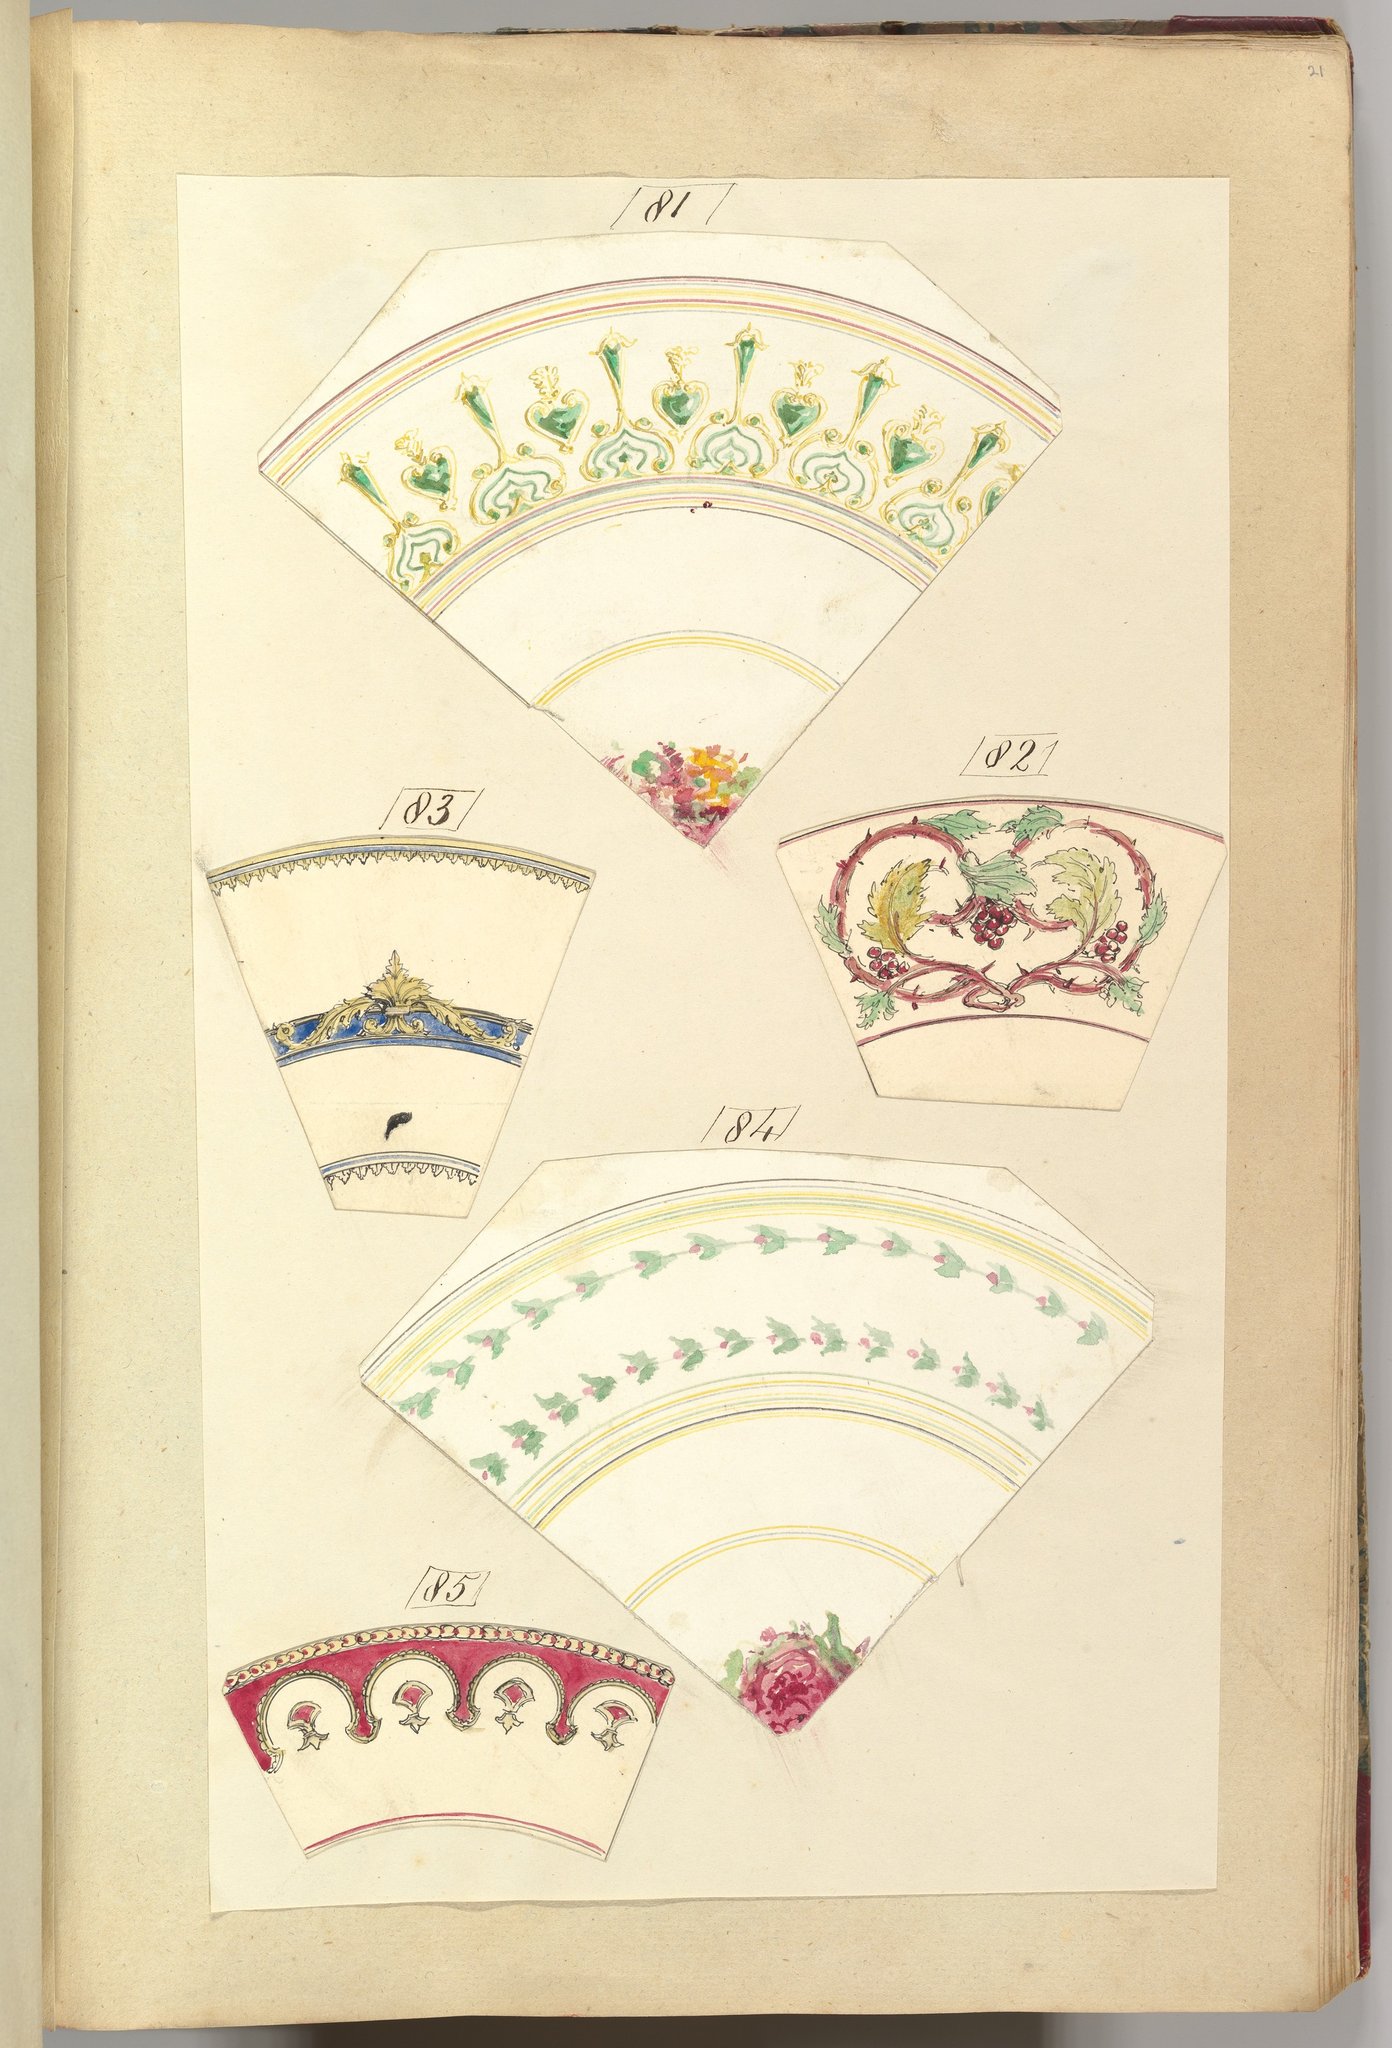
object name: drawing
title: Five Designs for Decorated Plates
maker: alfred henry forrester [alfred crowquill]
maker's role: artist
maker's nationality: british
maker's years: 1804-1872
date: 1845-1855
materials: ink, watercolor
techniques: pen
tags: ornament